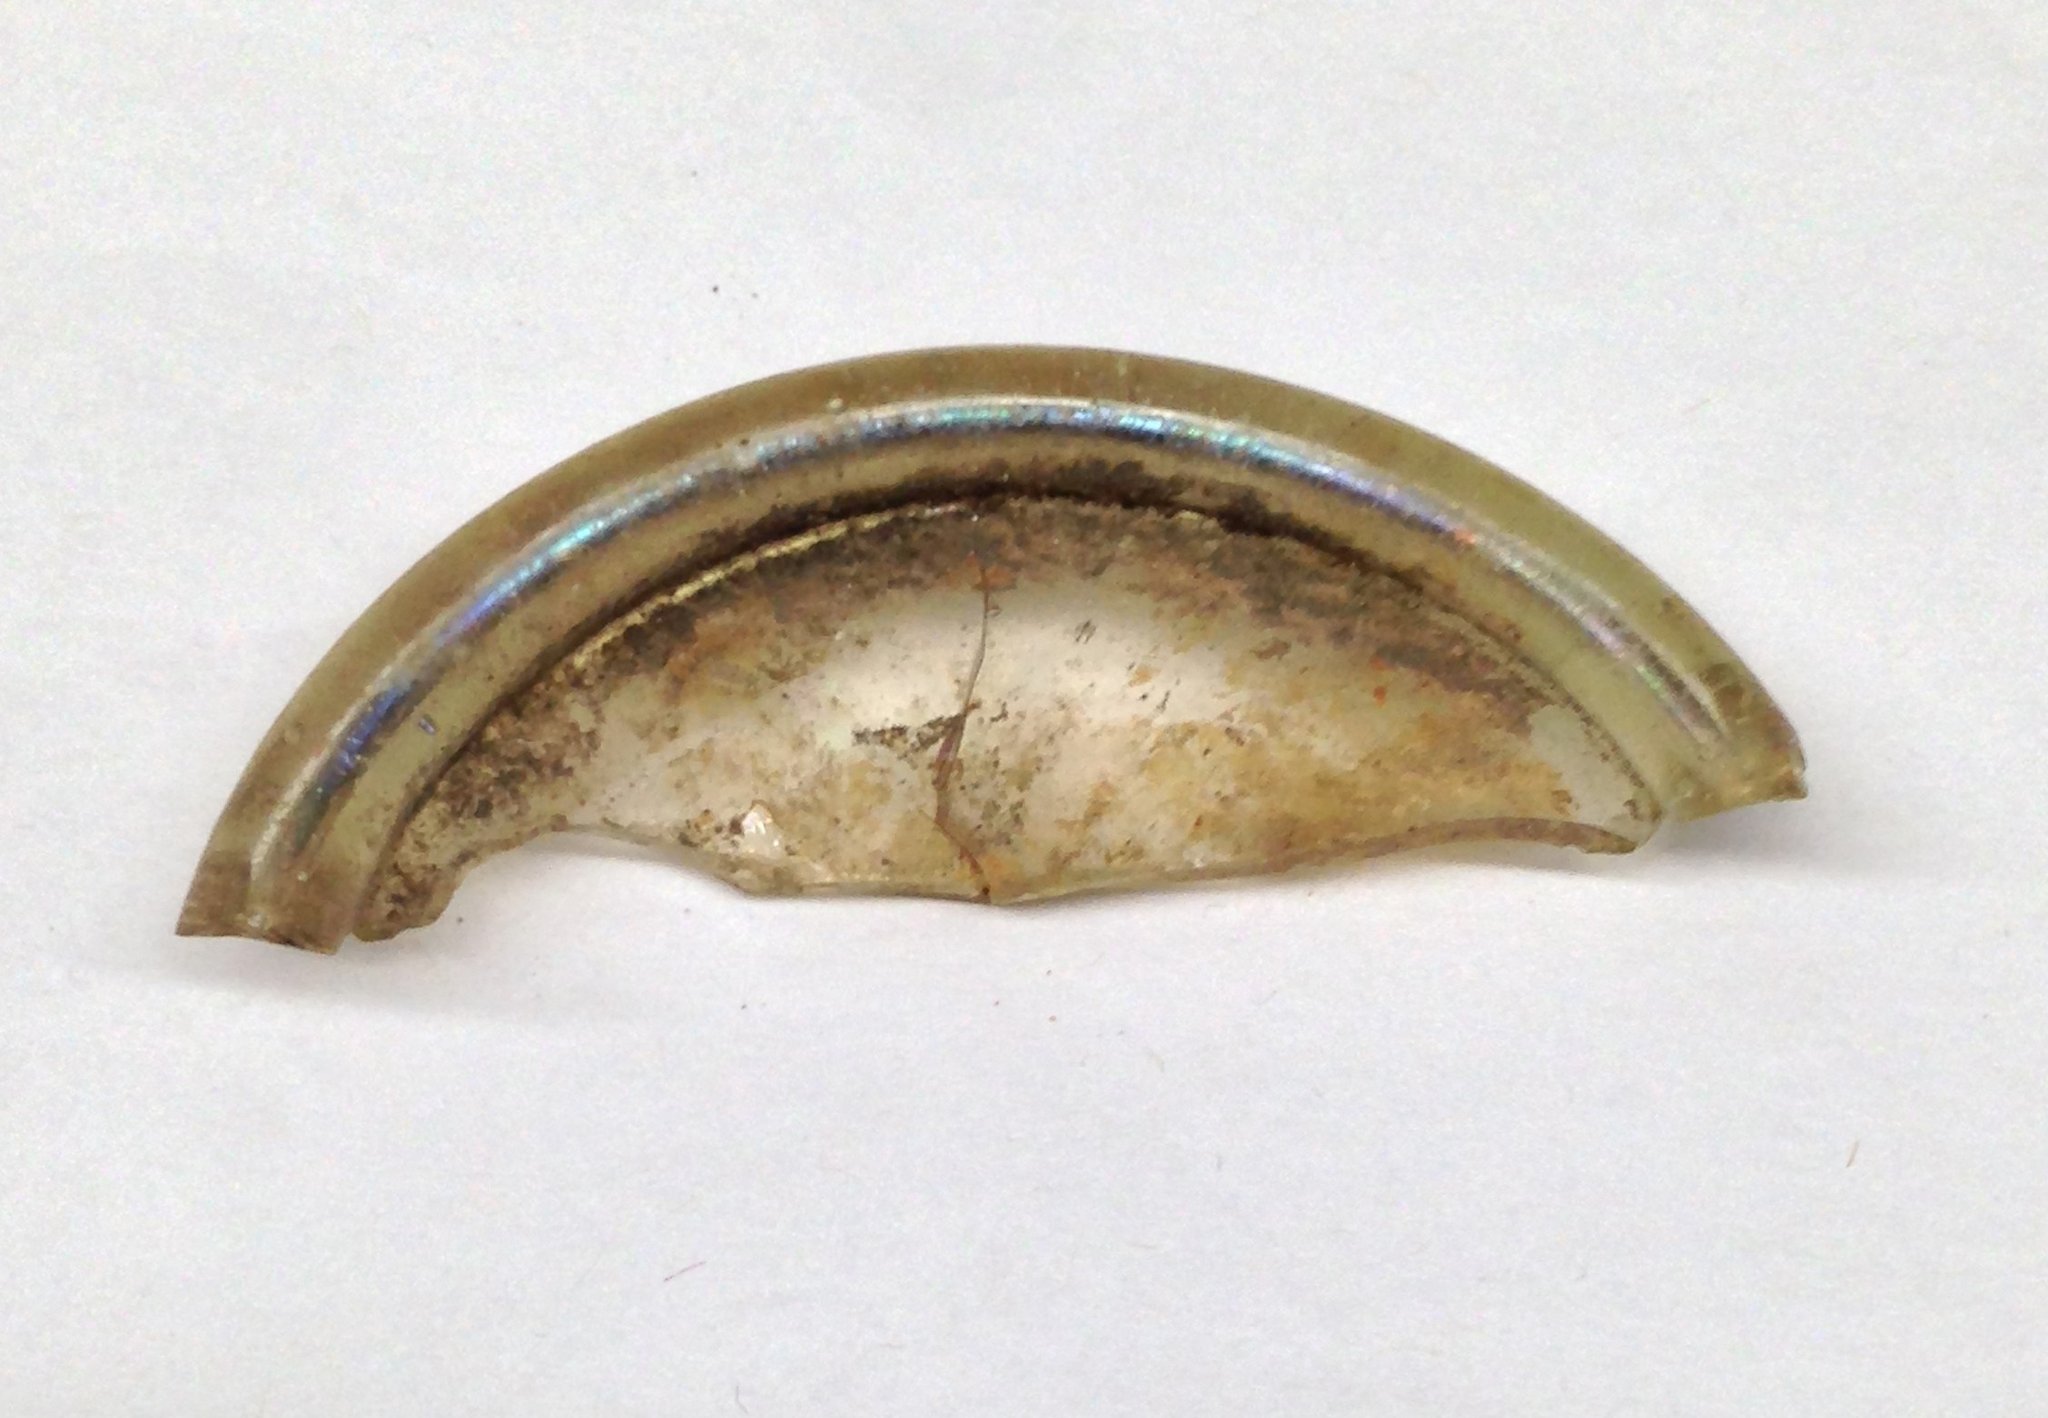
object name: fragment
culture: european or middle eastern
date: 1150-1250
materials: ceramic, glass